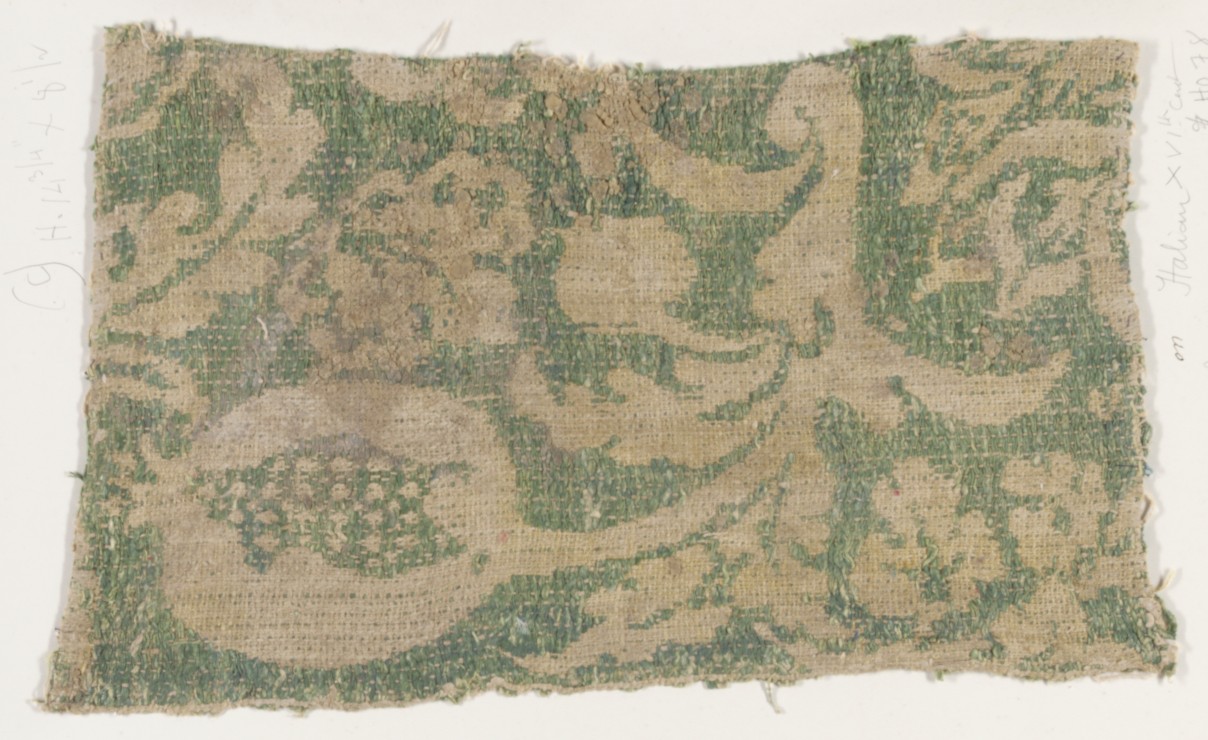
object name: fragment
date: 1501-1600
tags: pomegranates,leaves